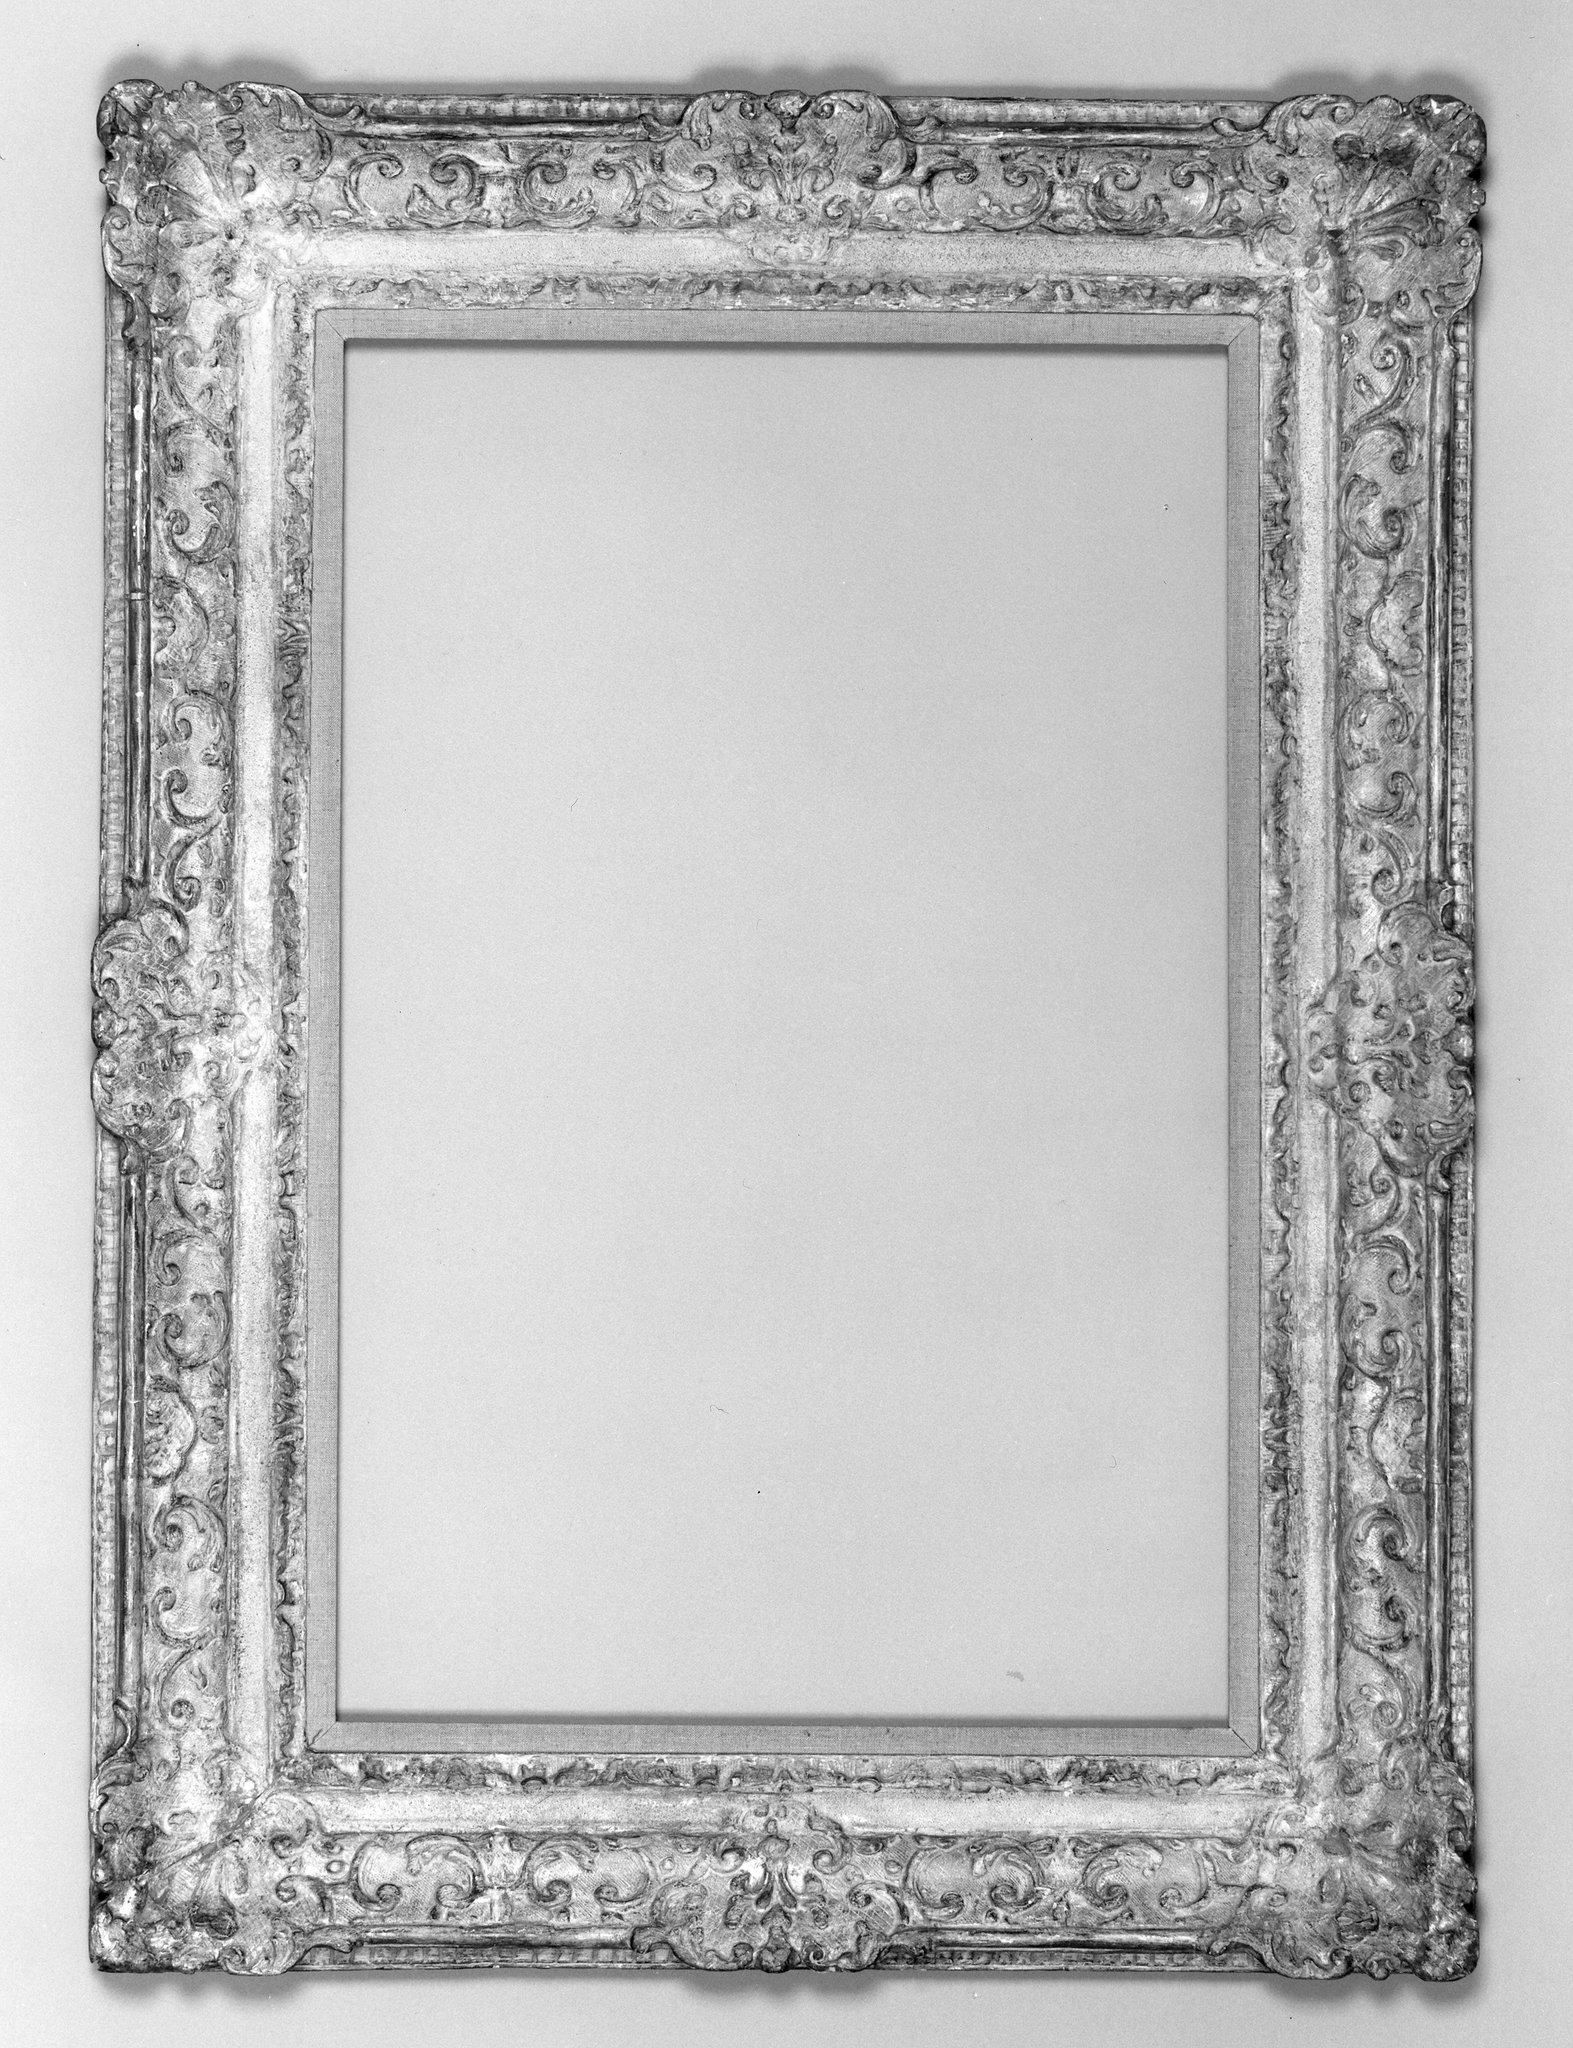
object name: frame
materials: wood